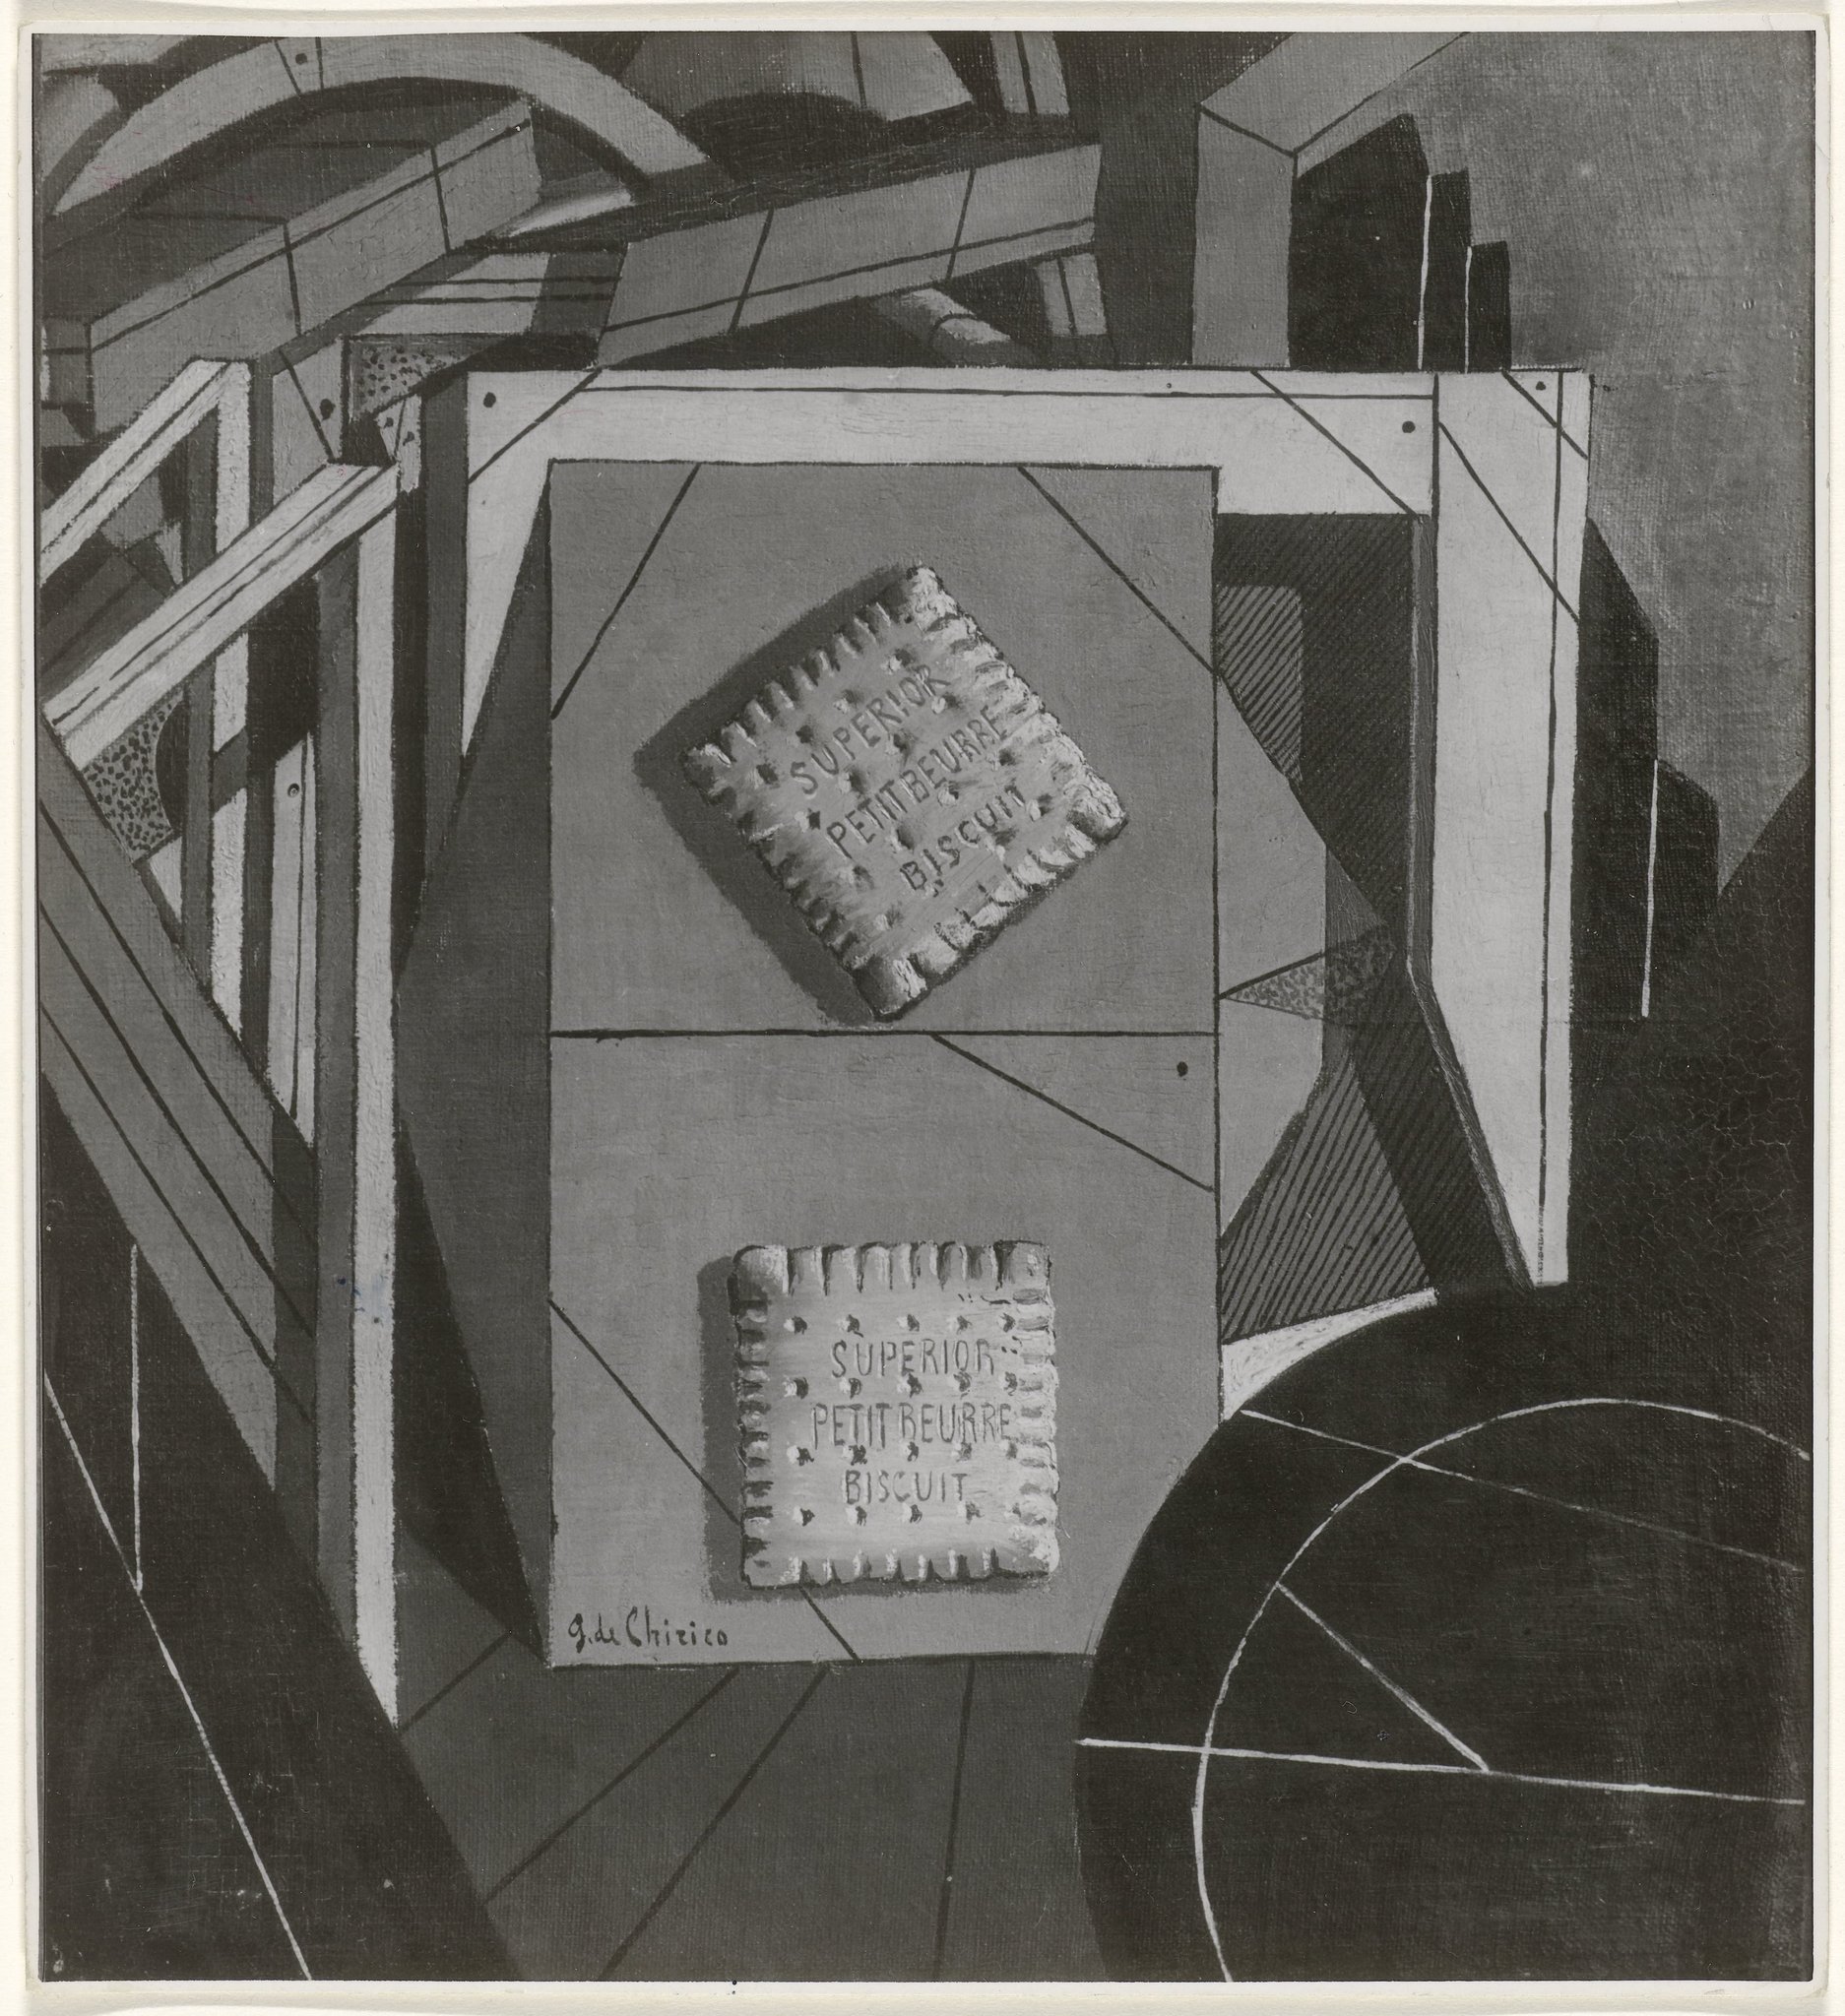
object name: photograph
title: Reproductie het schilderij La mort d'un esprit van De Chirico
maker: lilly samuel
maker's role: fotograaf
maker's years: 1909-1944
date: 1938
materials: photographic support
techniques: gelatin silver print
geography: amsterdam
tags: amsterdam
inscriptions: stamp: ‘galerie Robert Keizersgracht 527’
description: Onderdeel van een serie betreffende een reizende tentoonstelling "Exposition Internationale du Surréalisme", in galerie Robert te Amsterdam